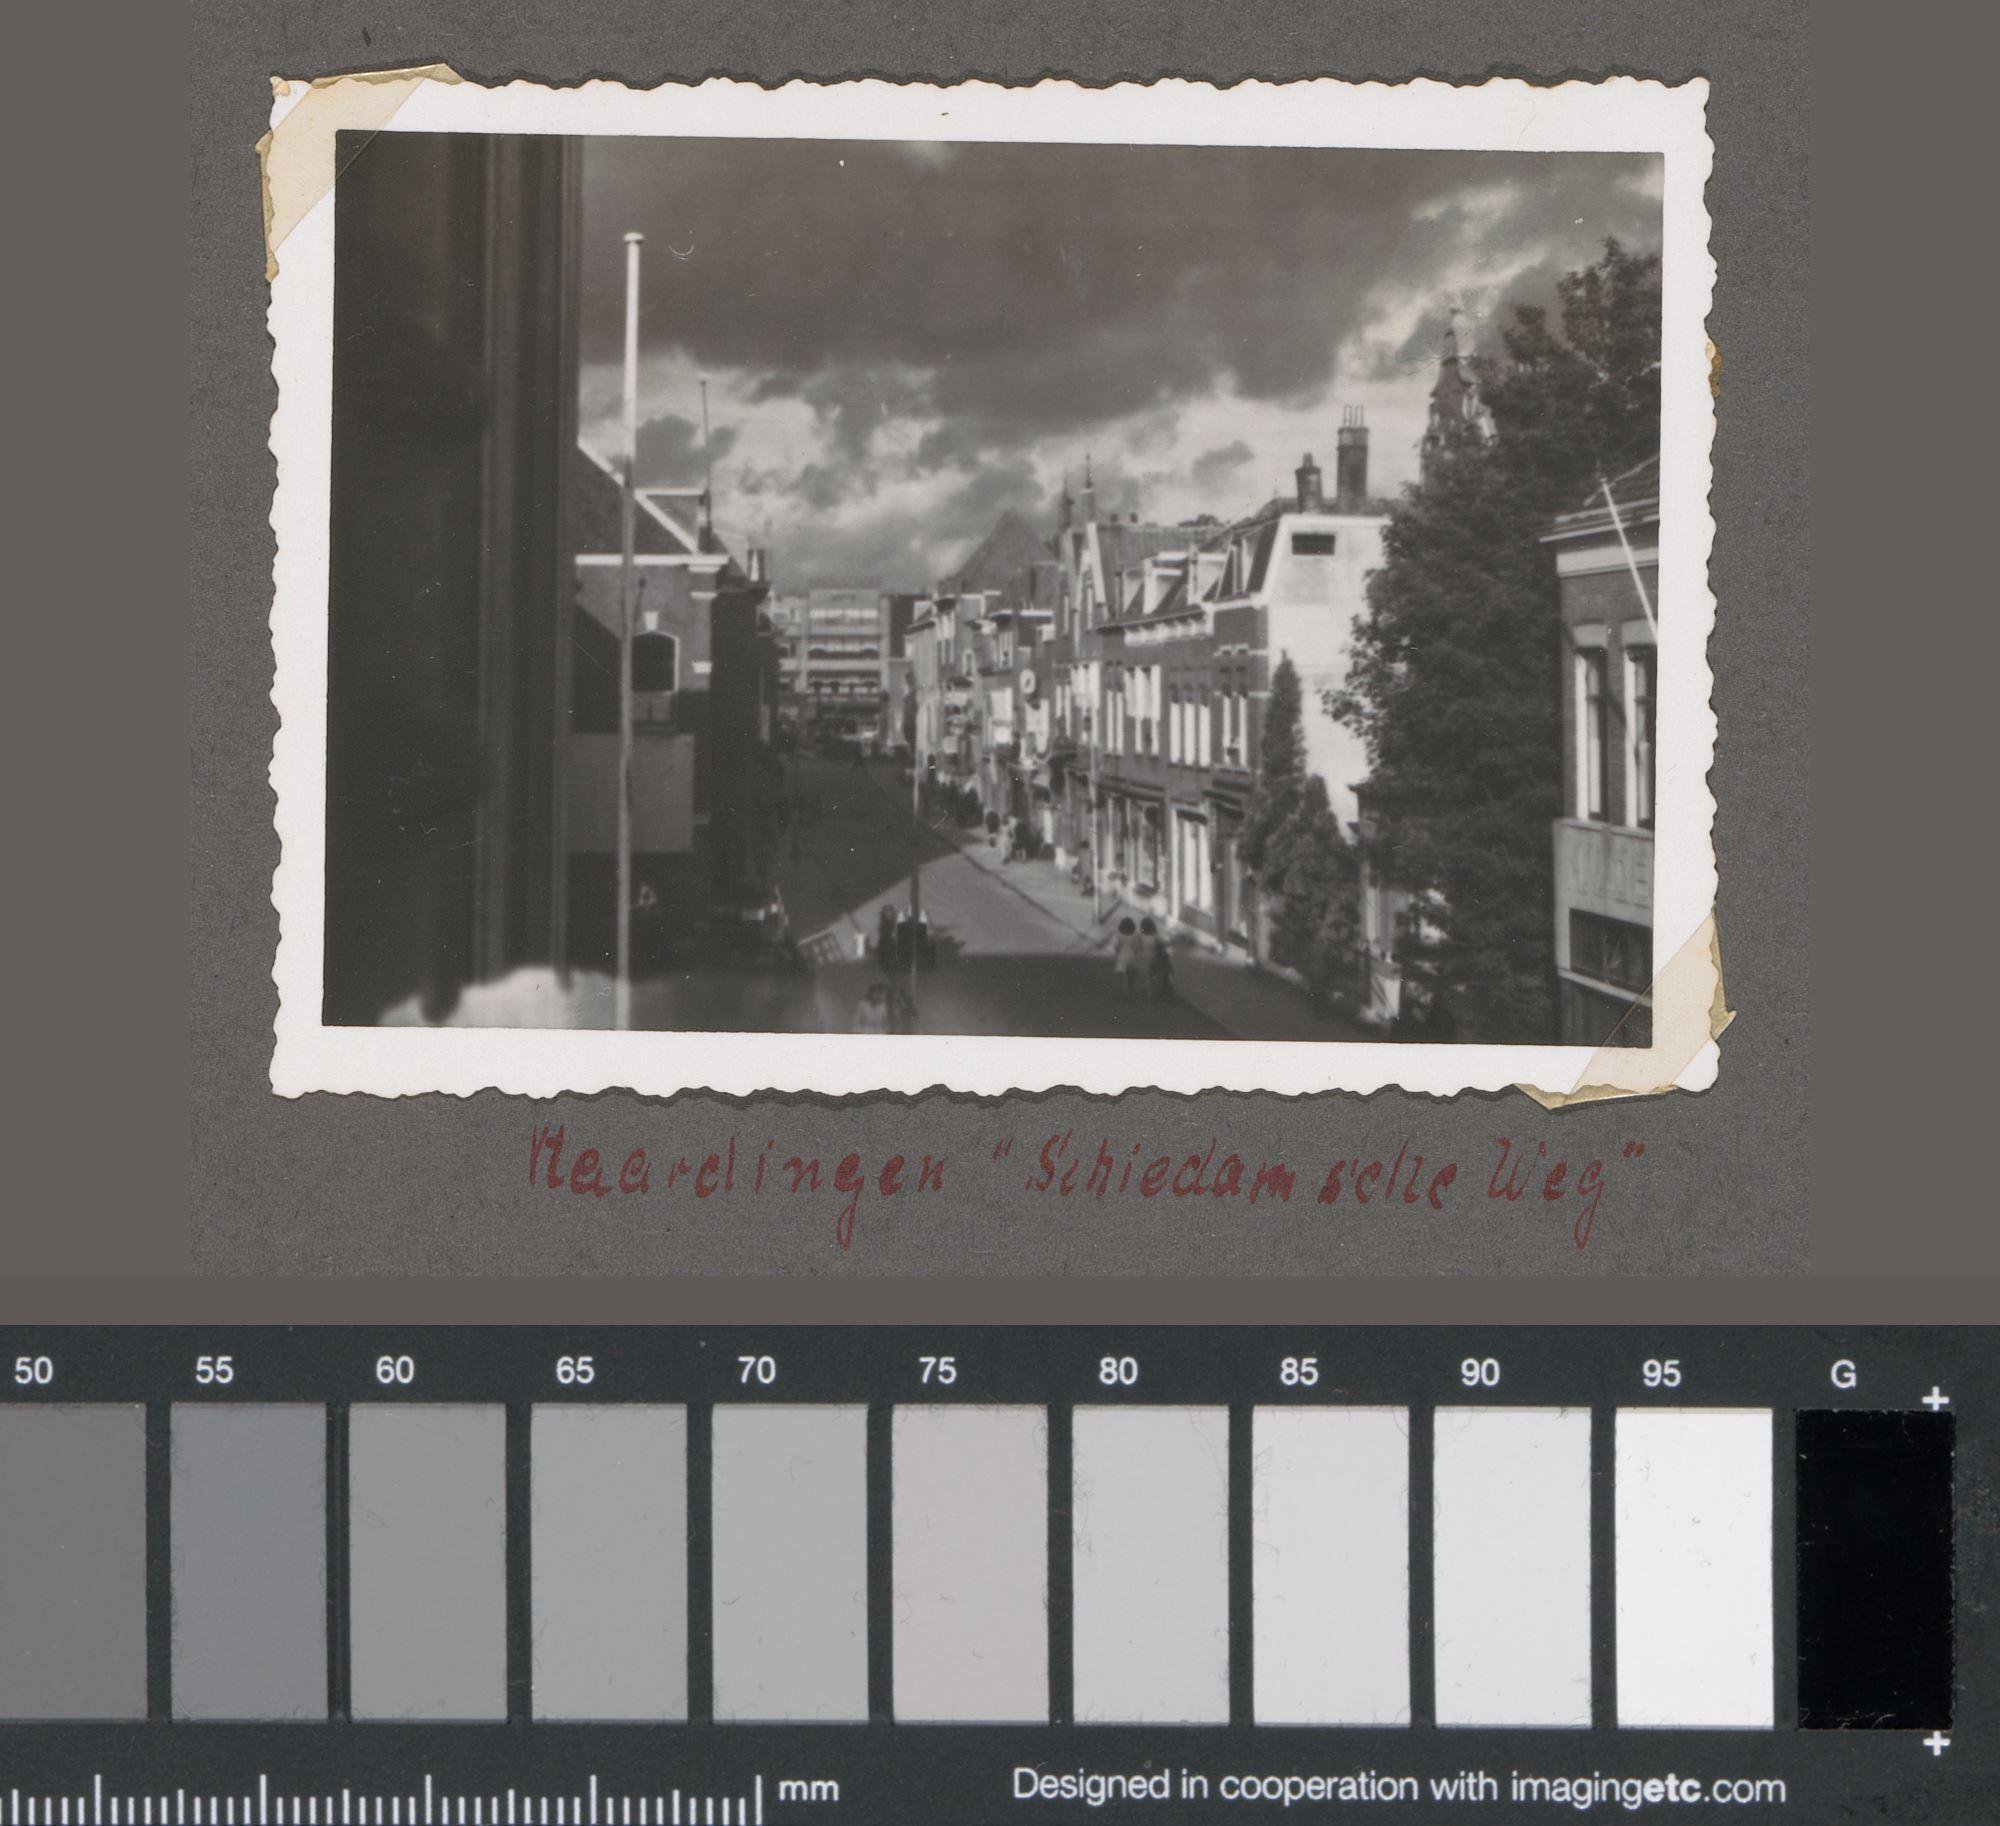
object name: photograph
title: Gezicht op de Schiedamseweg te Vlaardingen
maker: Anonymous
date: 1941-1945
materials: paper, photographic support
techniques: gelatin silver print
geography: vlaardingen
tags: street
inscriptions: annotation: ‘Vlaardingen - Schiedamscheweg’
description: Gezicht op de Schiedamseweg te Vlaardingen in noordwestelijke richting, met aan het einde de brug over de Oude Haven en enkele panden van de Westhavenplaats. Links vooraan met vlaggenmast op de stoep de Dienststelle van de Duitse Kriegsmarine en geheel rechts vooraan Zaal Harmonie.